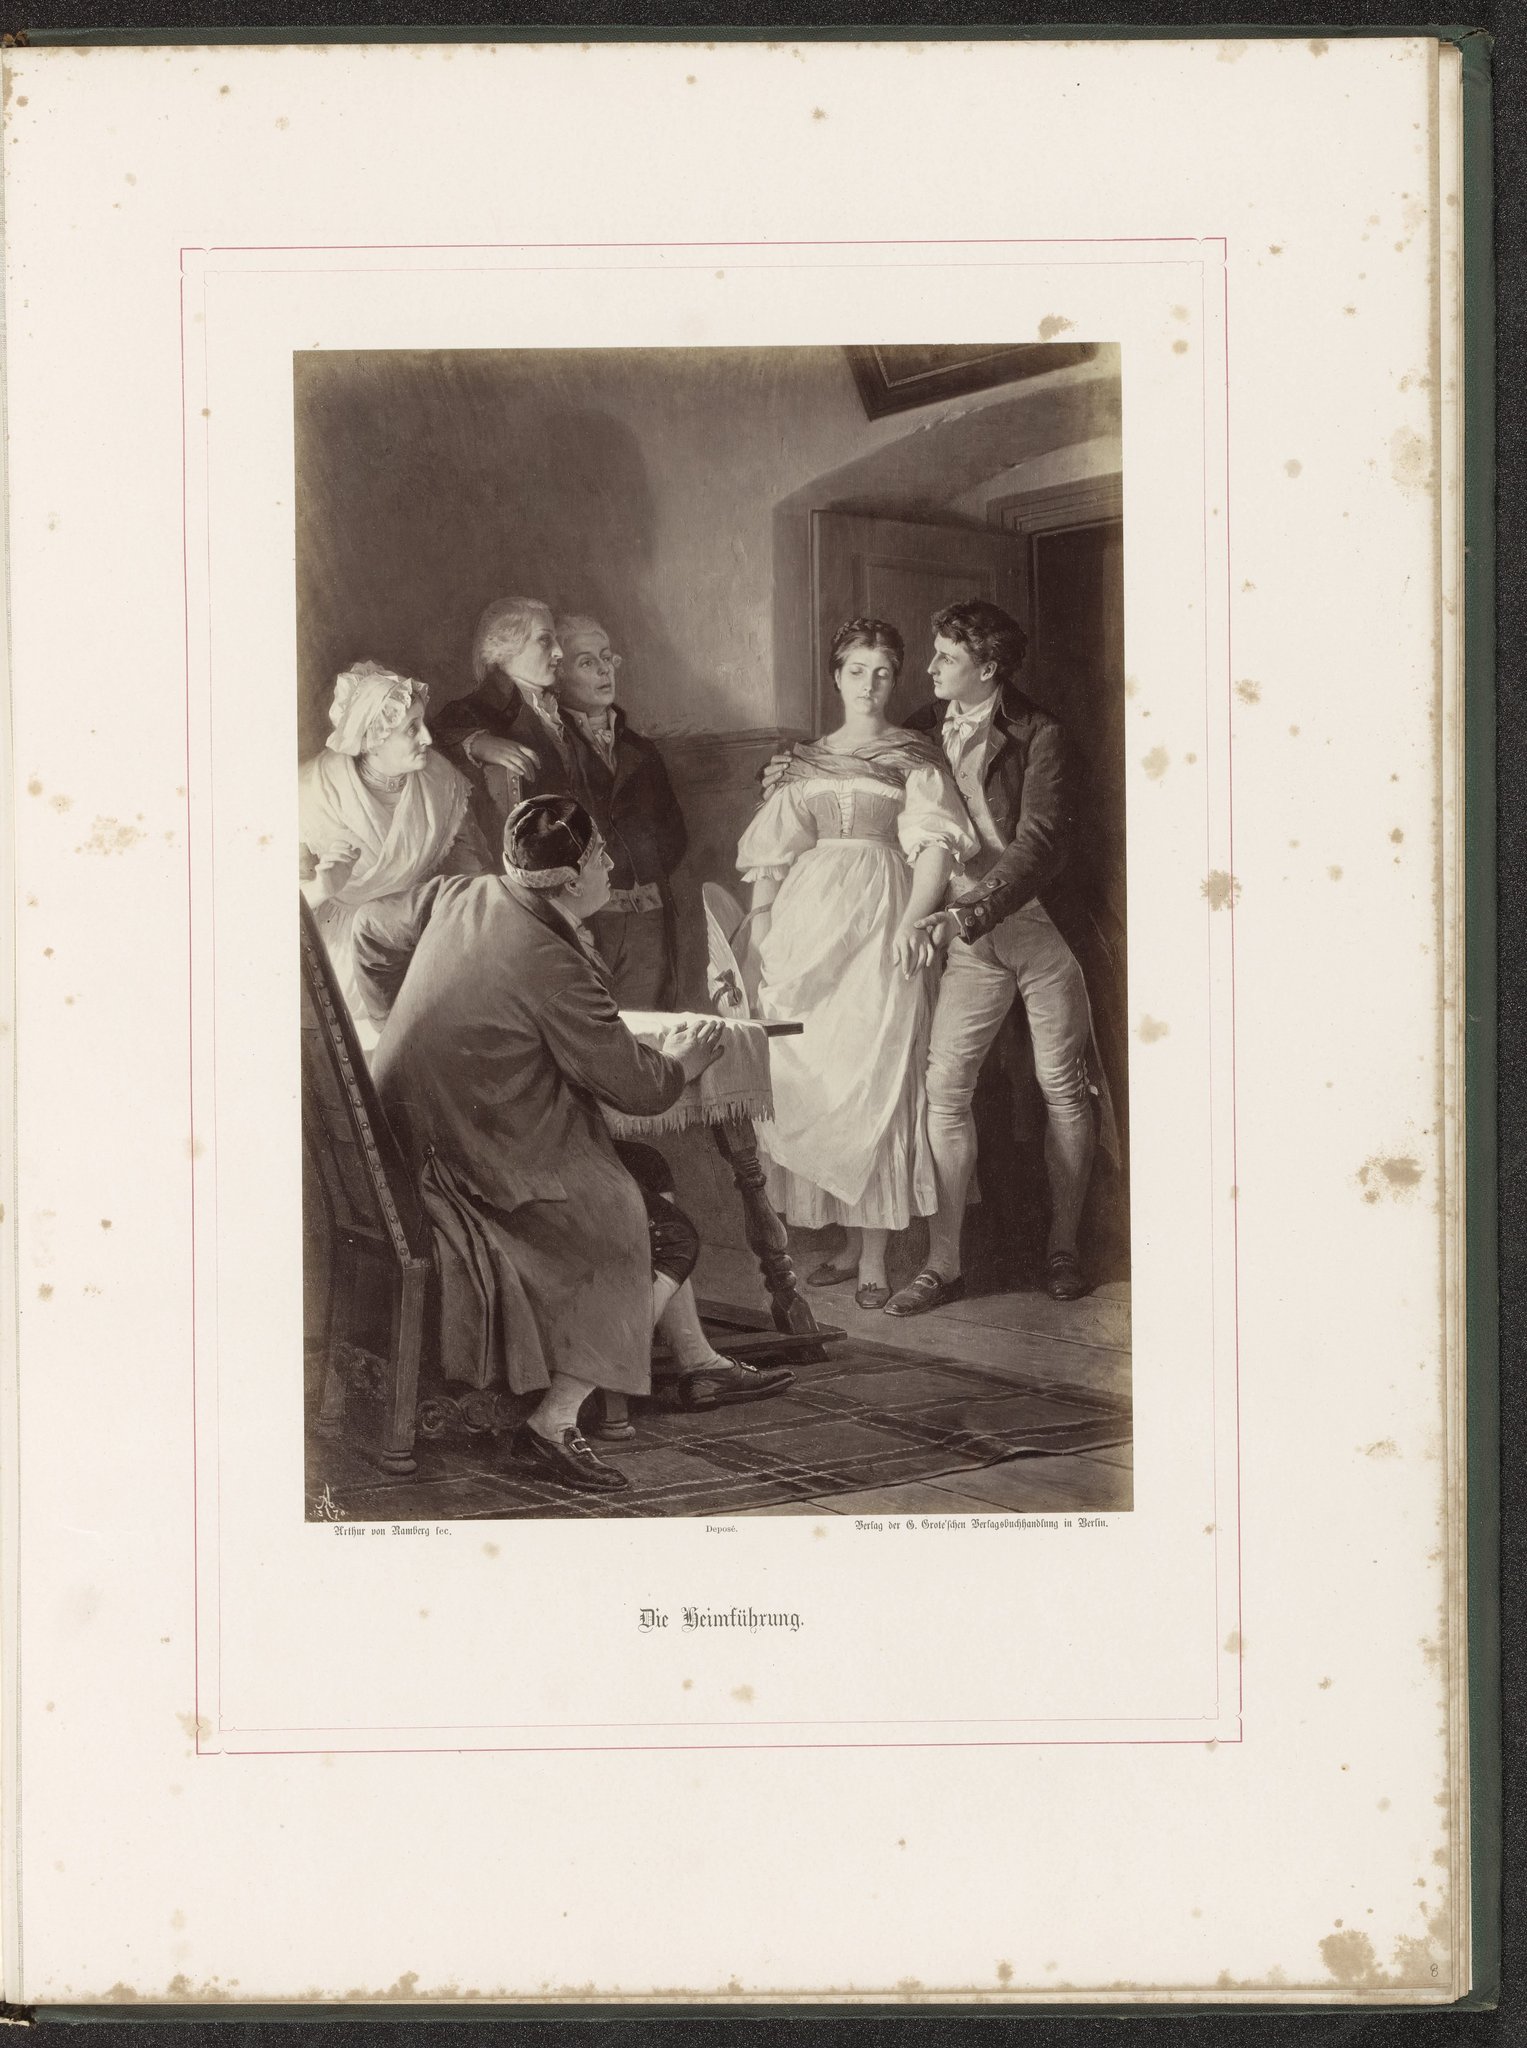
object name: photograph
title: Die Heimführung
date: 1871-1872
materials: photographic support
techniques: albumen print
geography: berlin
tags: adolescent, young woman, maiden, parents with their children, youth, adolescent, couple of lovers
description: Onderdeel van Album met fotoreproducties van schilderijen van A.G. von Ramberg naar het werk 'Hermann und Dorothea' van J.W. von Goethe.